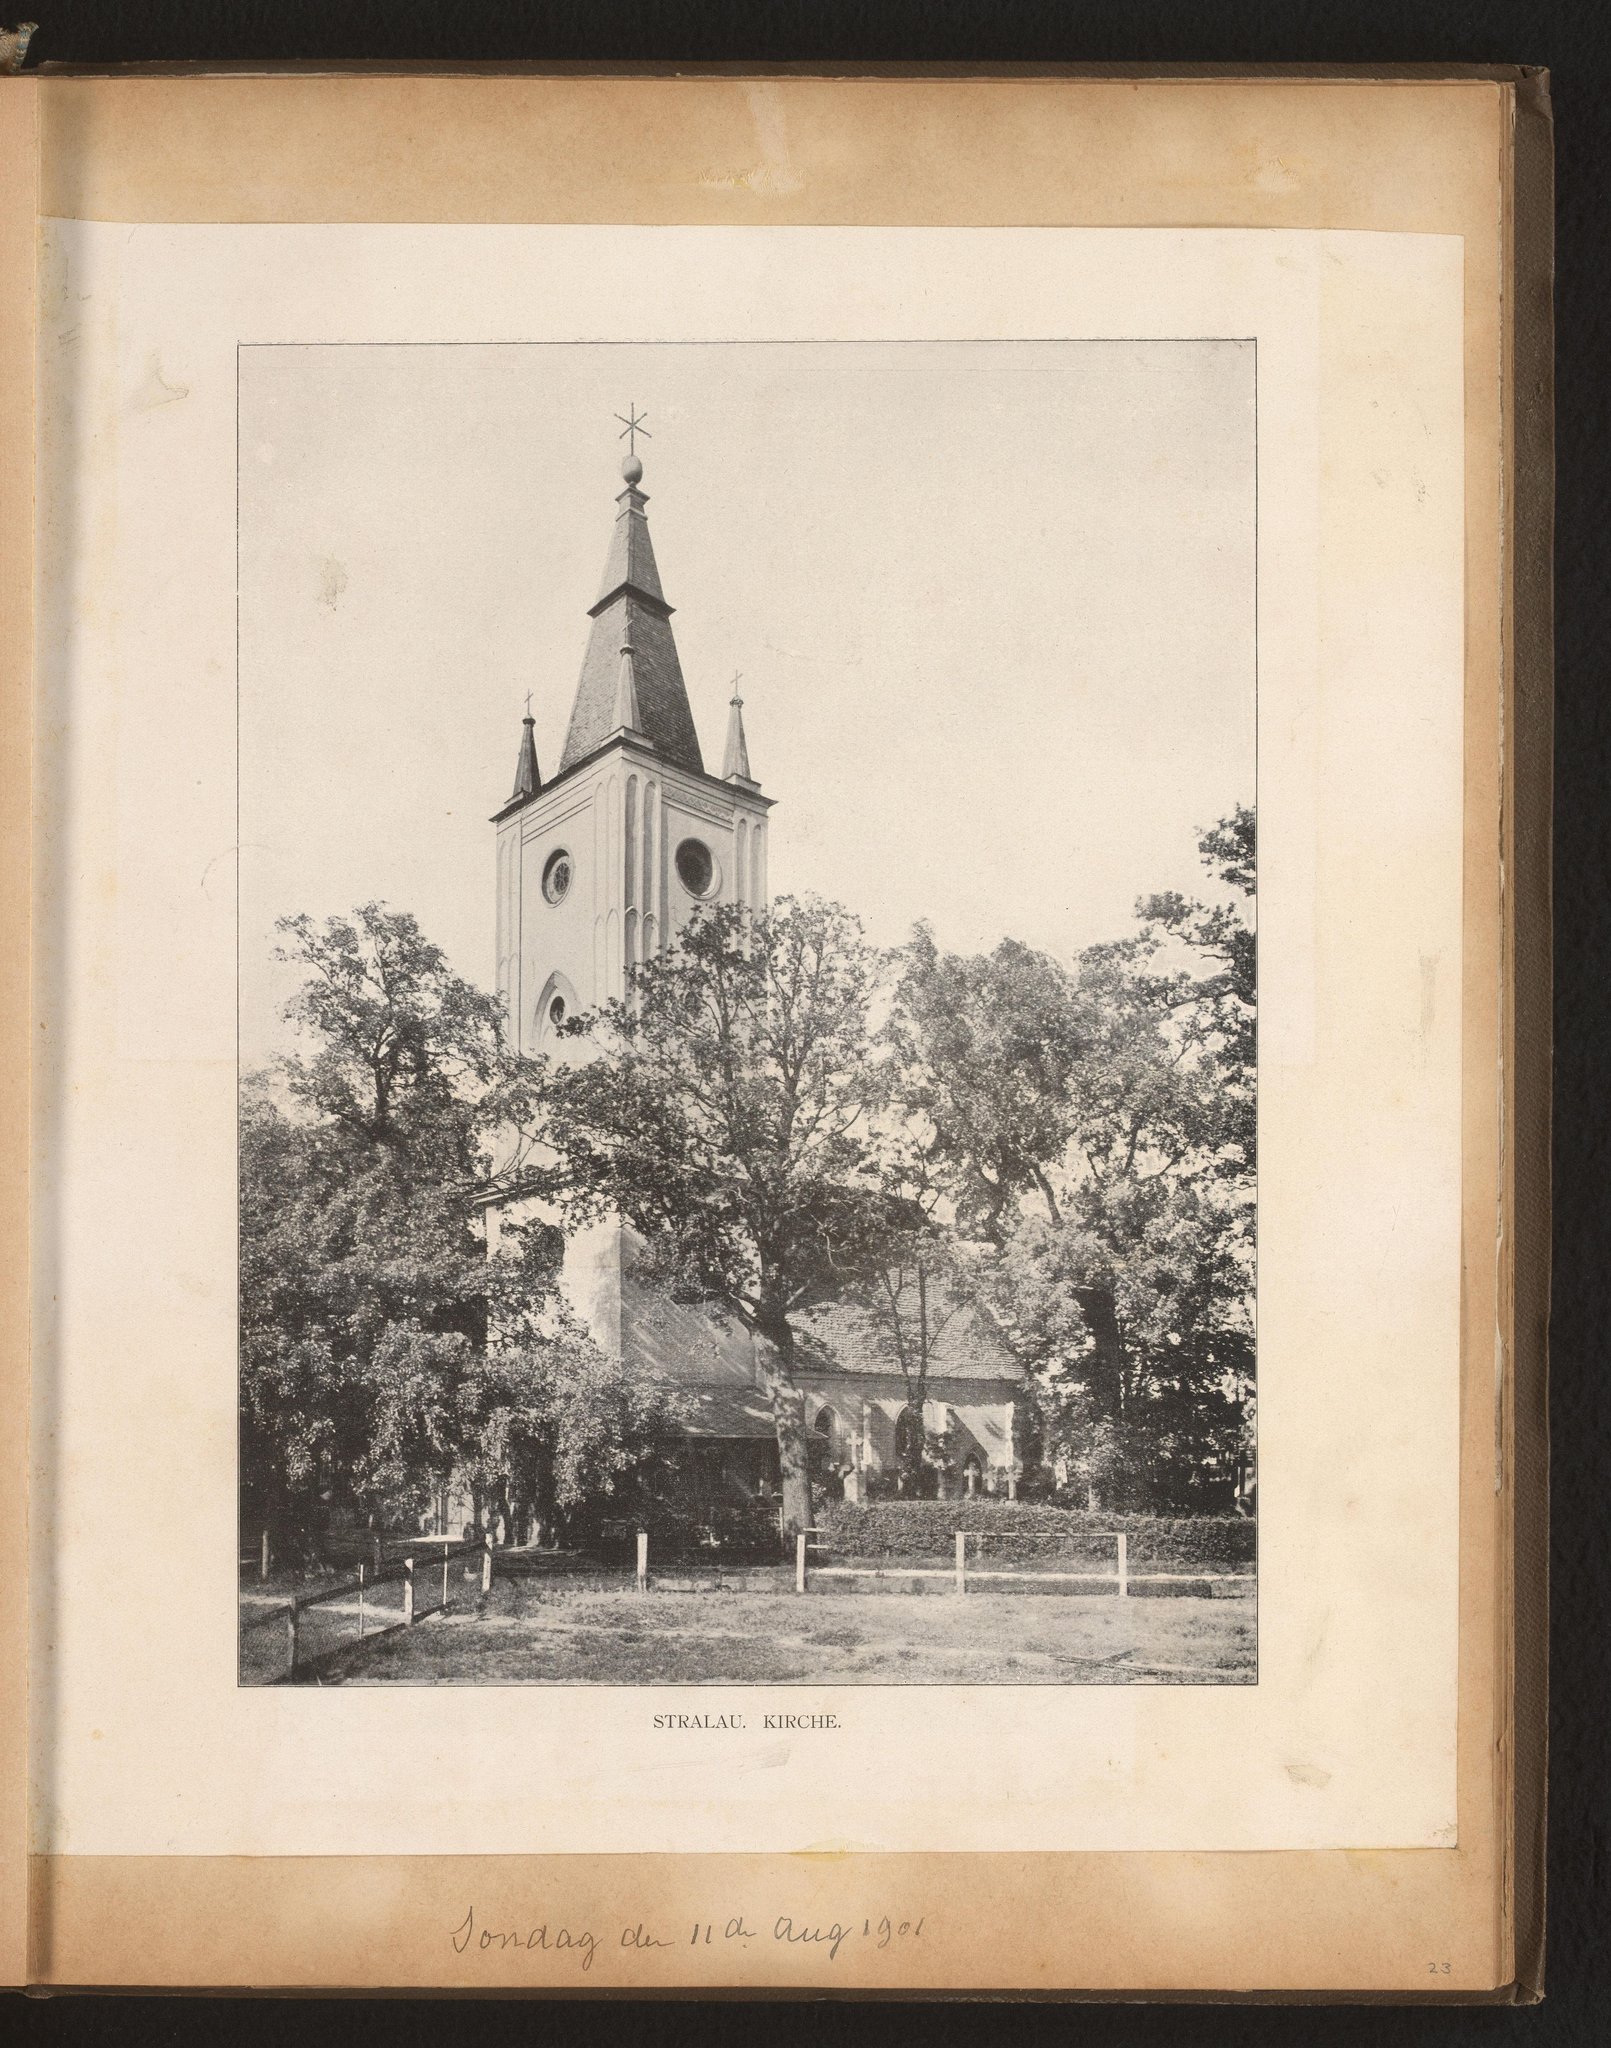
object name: photomechanical print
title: Dorpskerk van Stralau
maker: Anonymous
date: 1896-1901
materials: paper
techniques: autotype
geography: berlin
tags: church (exterior)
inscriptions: inscription: ‘Zondag den 11de Aug 1901’, title: ‘Stralau. Kirche.’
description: Deze fotomechanische afdruk maakt deel uit van een album.